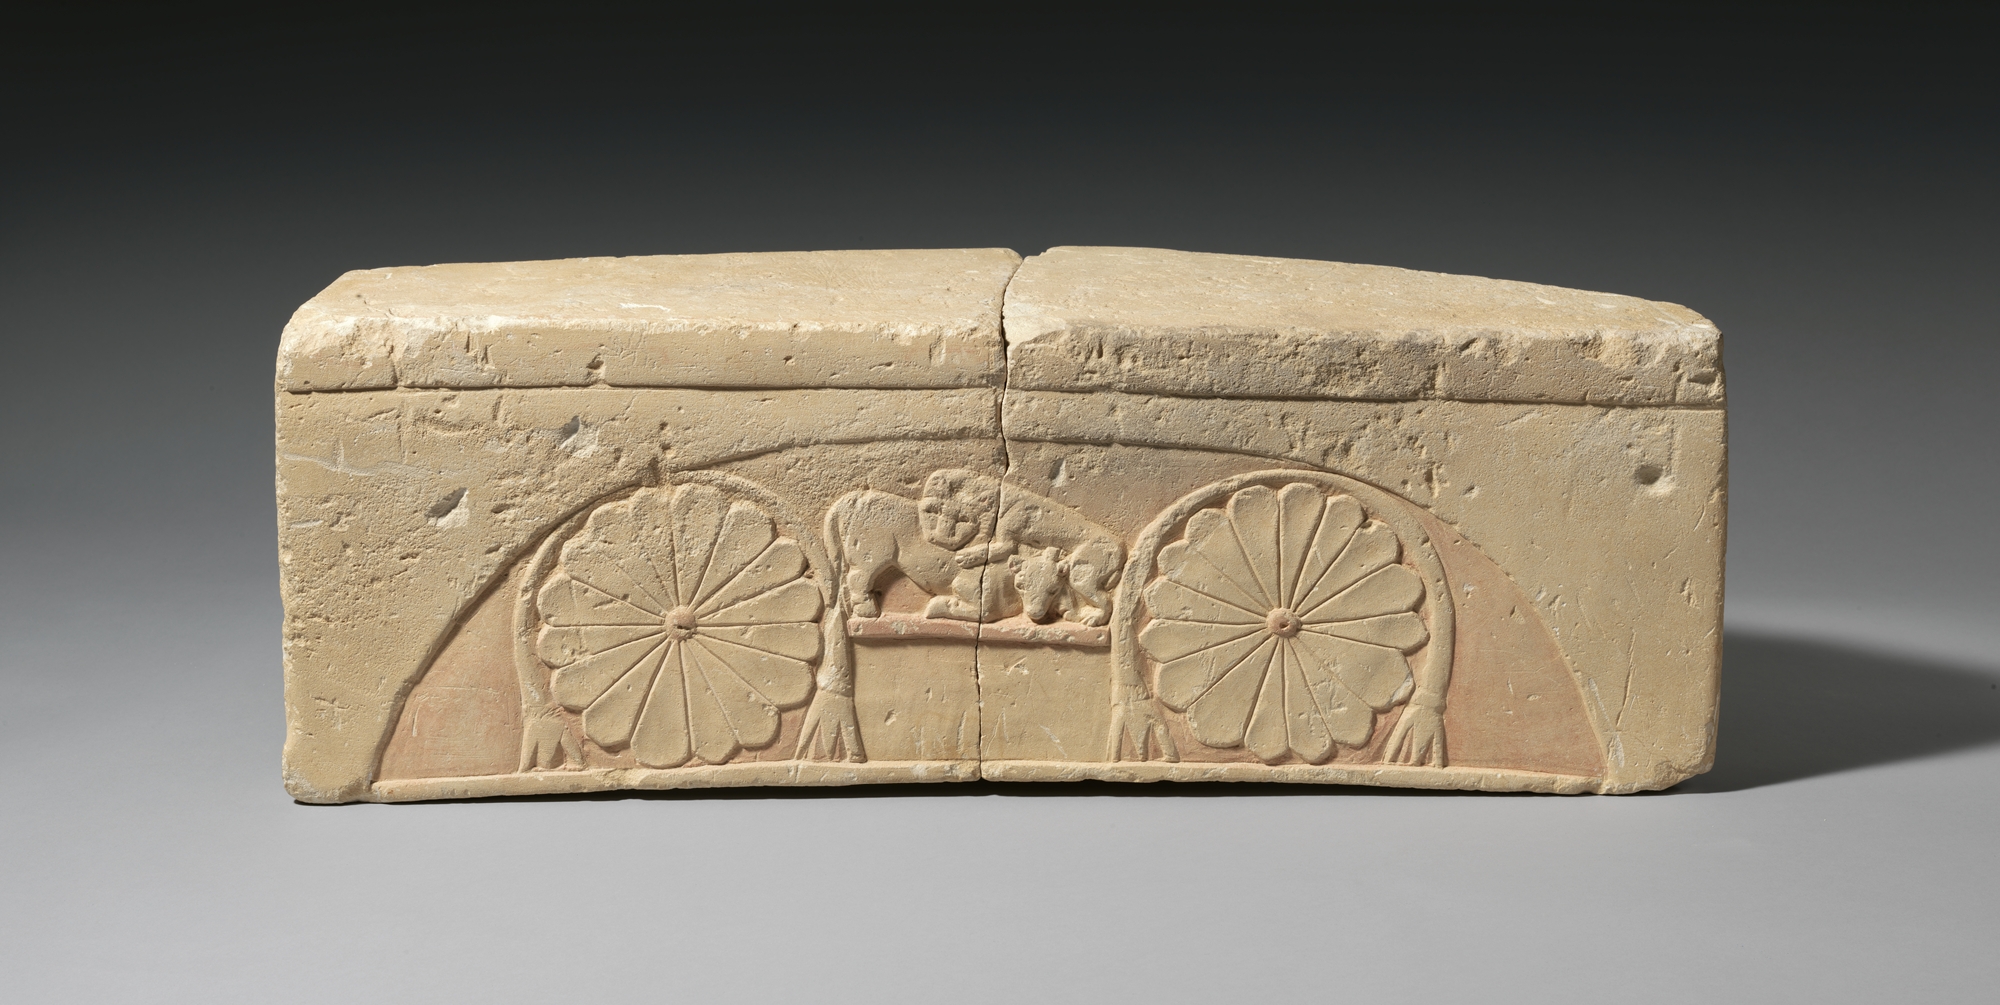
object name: footstool, votive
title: Limestone footstool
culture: cypriot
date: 500-451 BCE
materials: limestone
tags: bulls,lions,stools